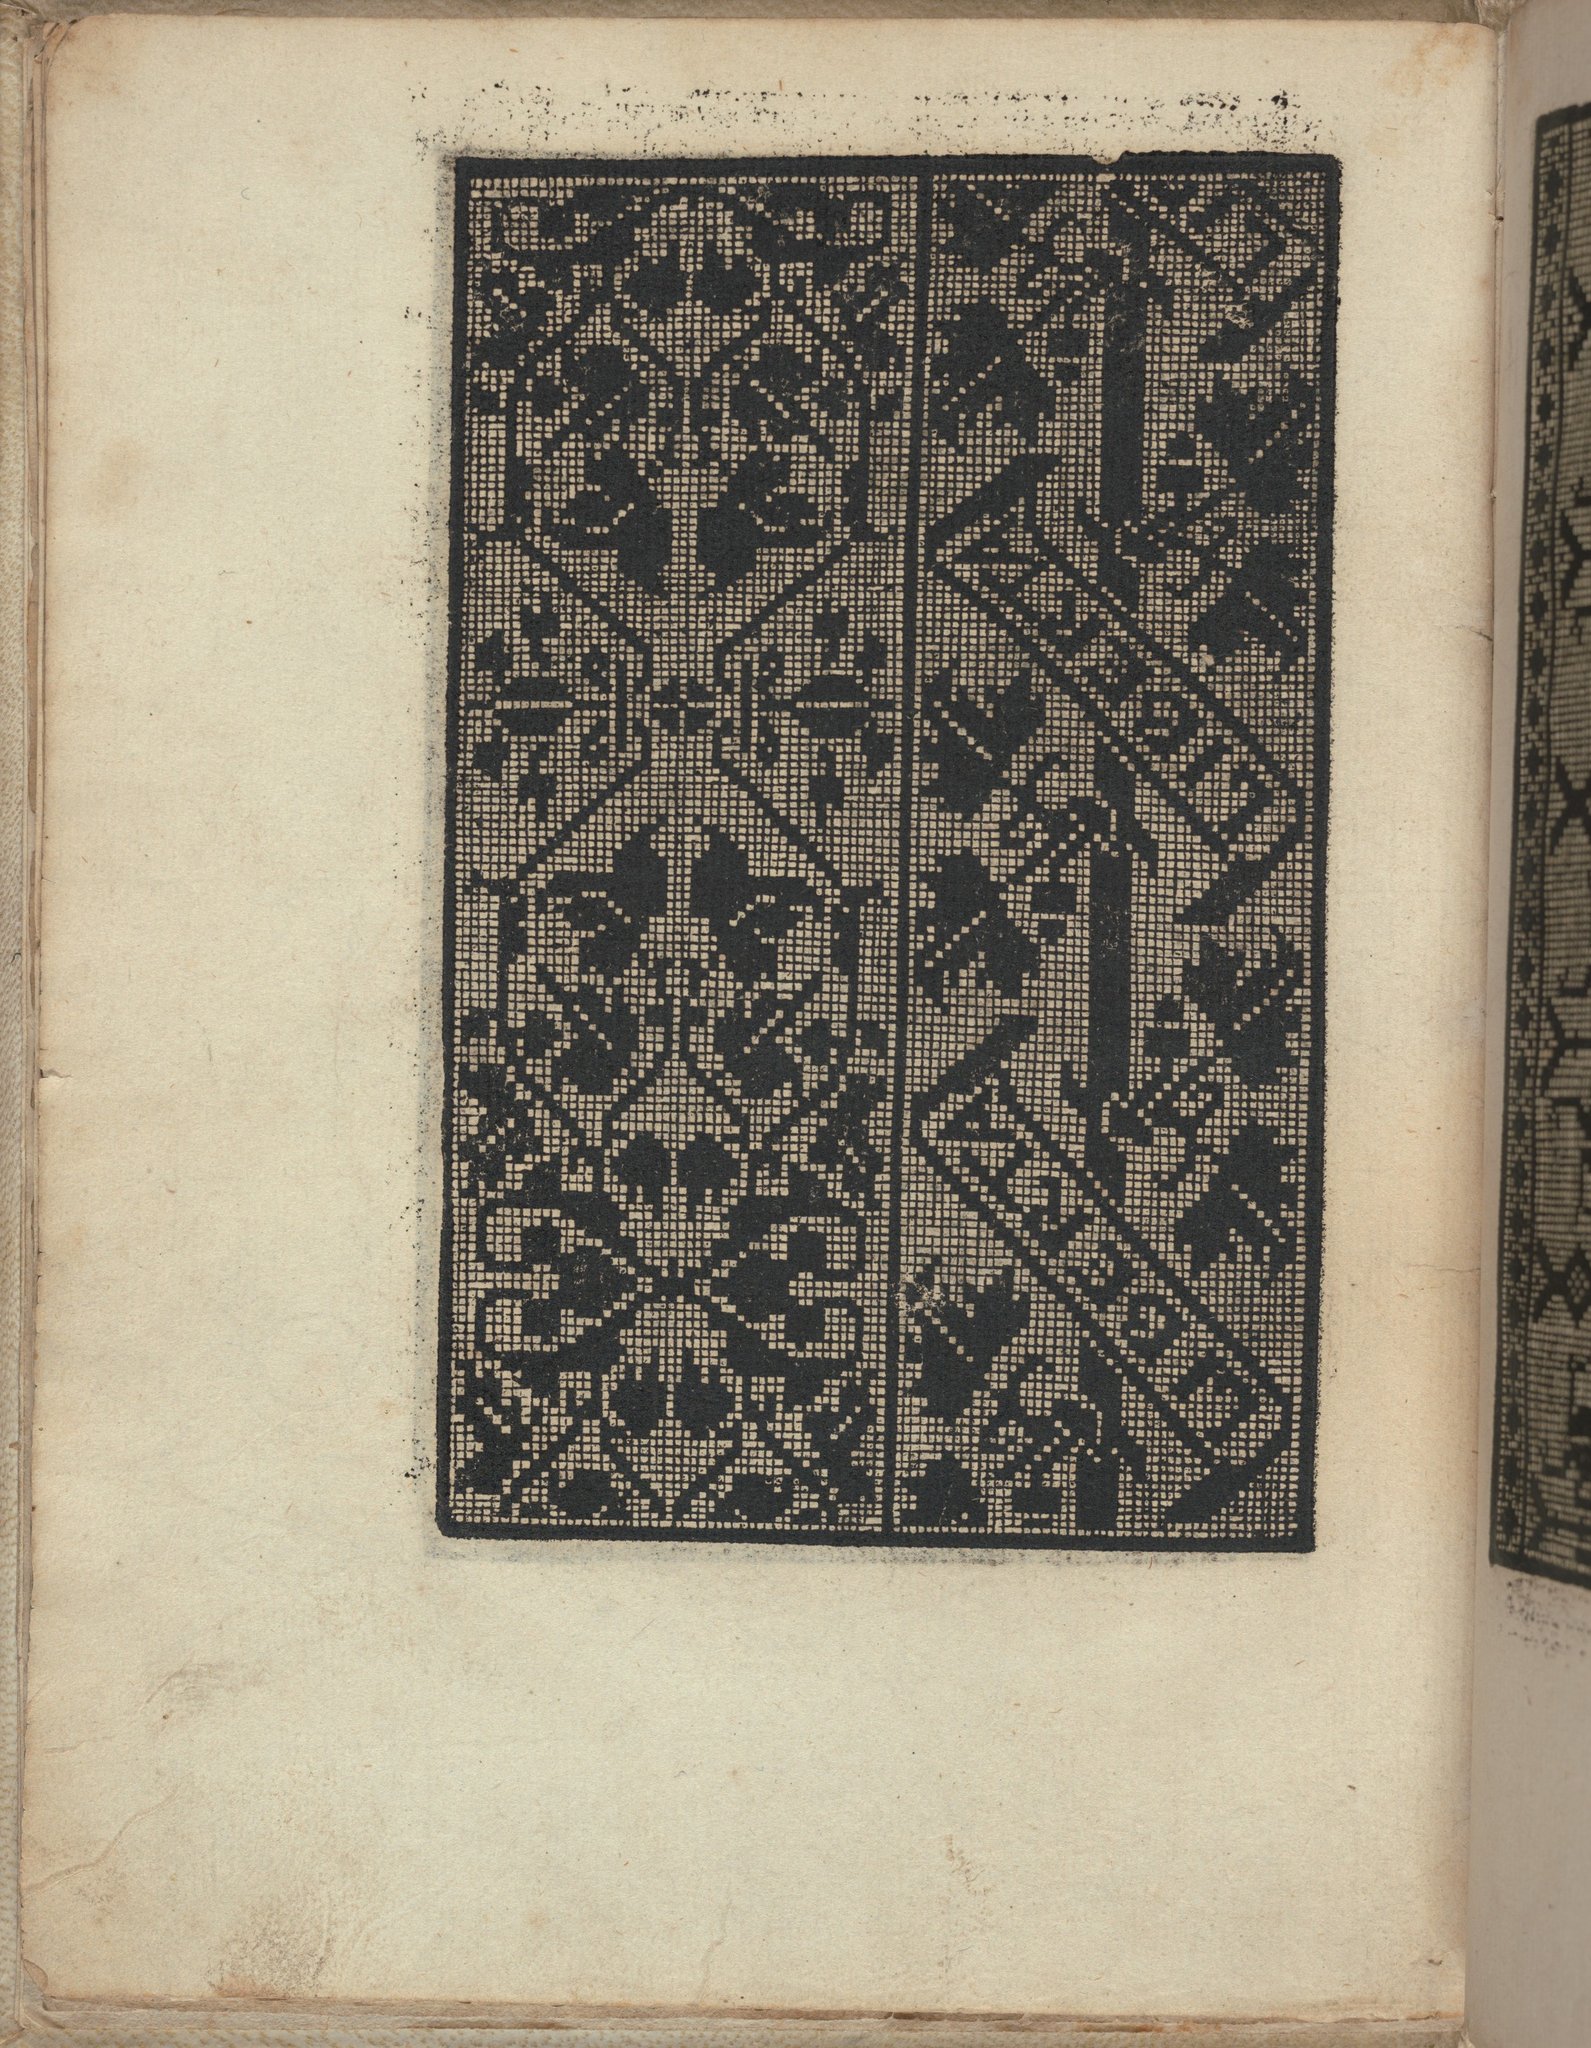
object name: book print ornament architecture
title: Esemplario di Lauori..., page 11 (verso)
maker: giovanni andrea vavassore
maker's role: publisher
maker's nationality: italian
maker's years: 1530-1573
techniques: woodcut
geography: venice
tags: animals,flowers